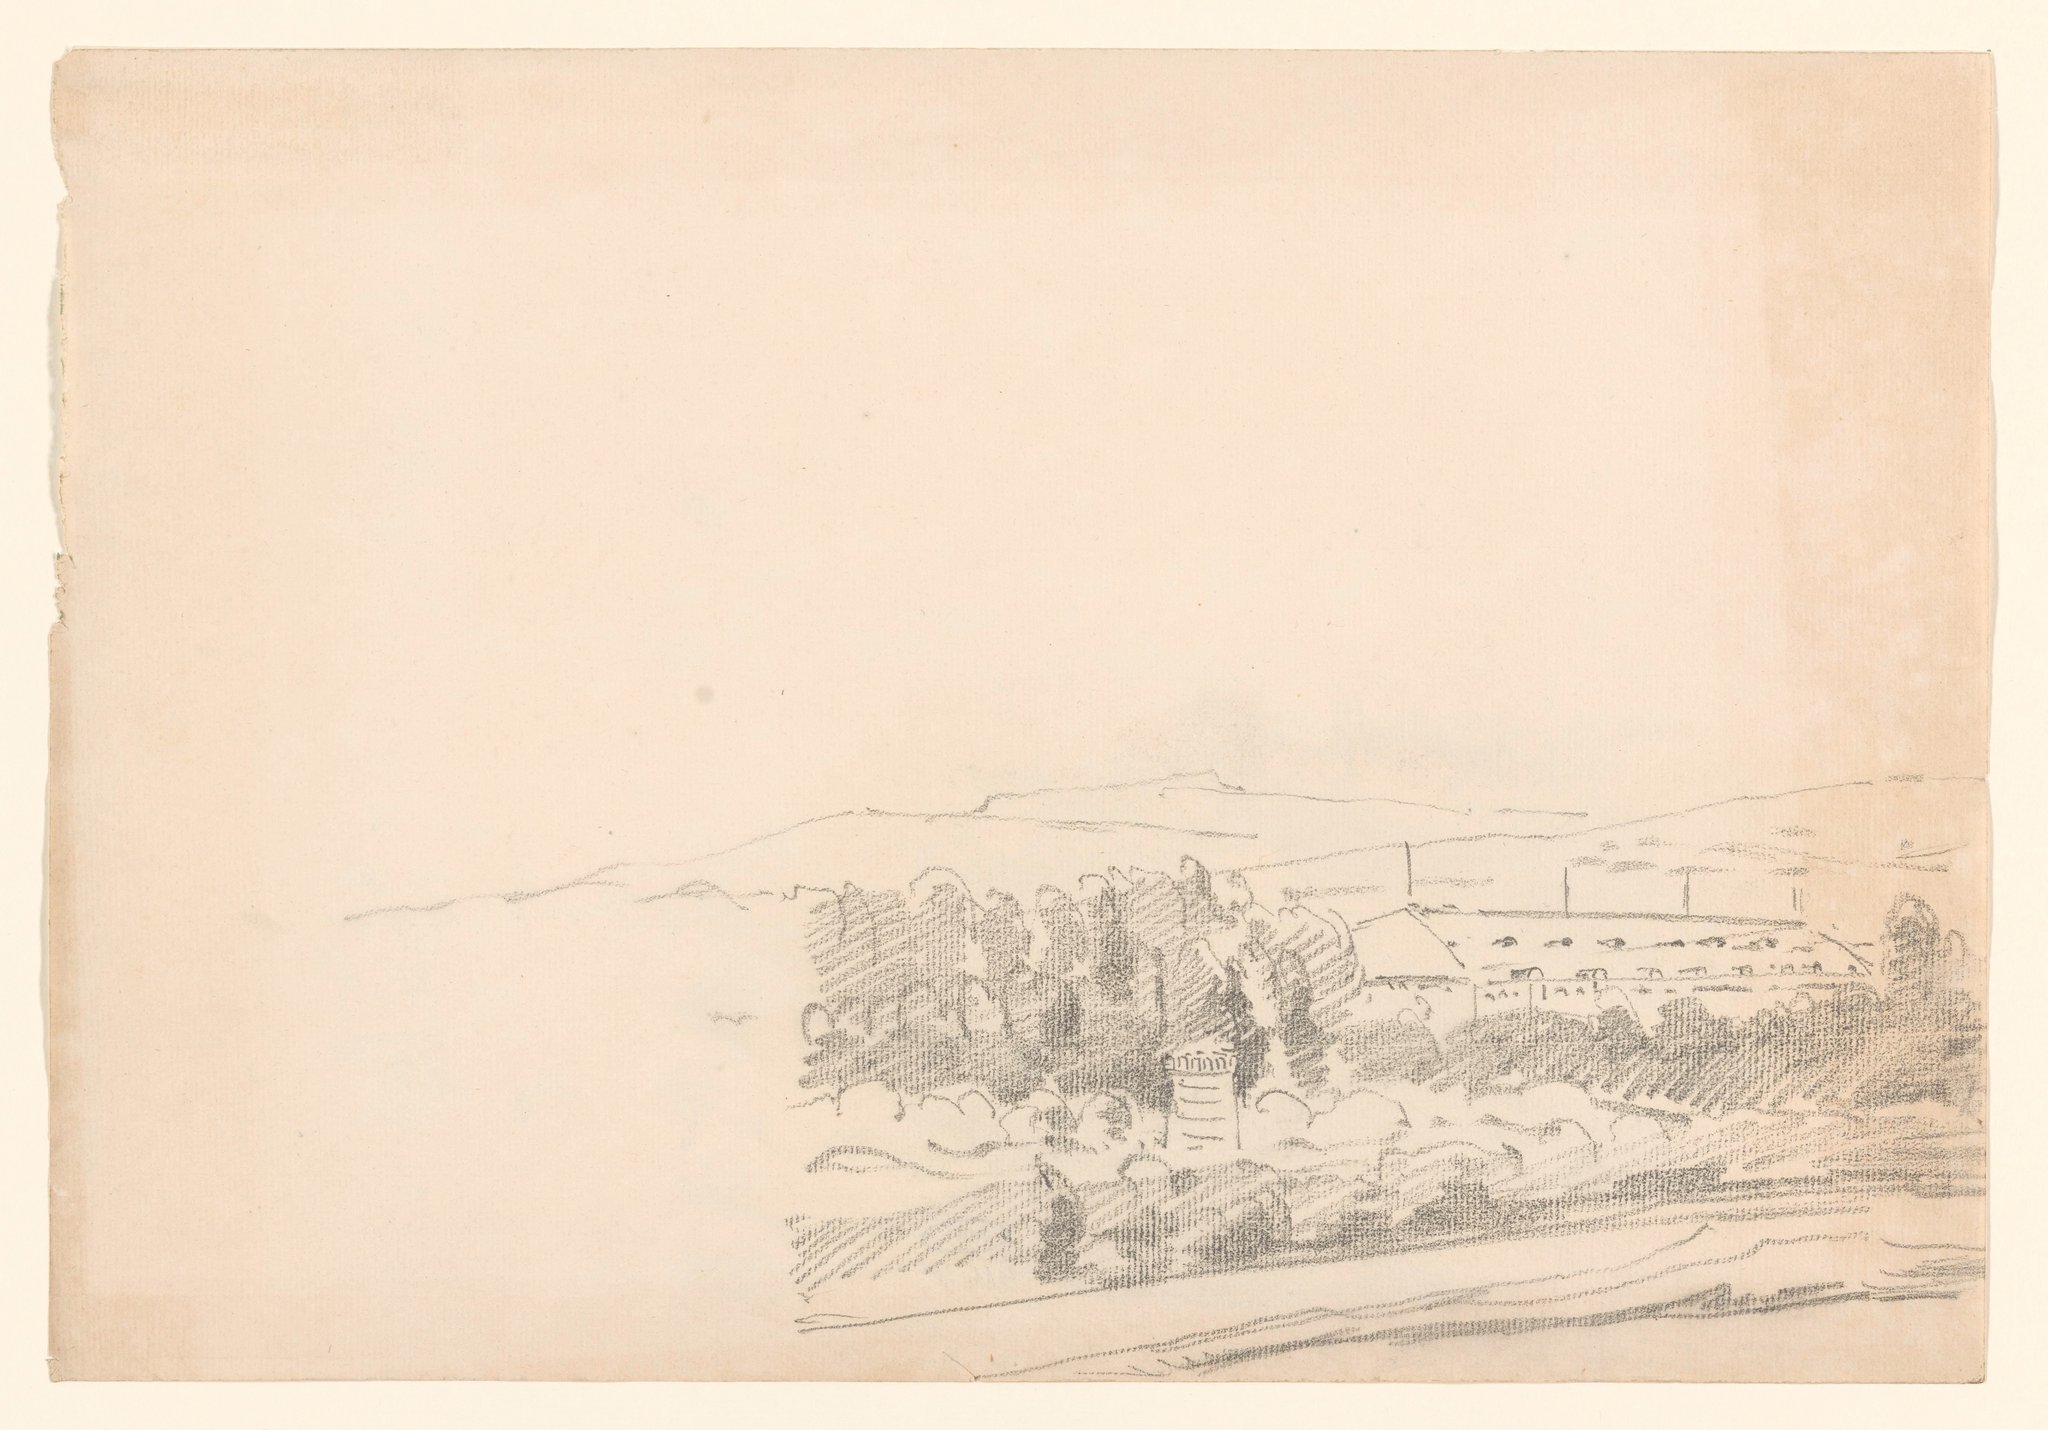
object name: drawing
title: Italiaans landschap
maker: carel vosmaer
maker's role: draughtsman, print maker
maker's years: 1826-1888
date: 1836-1888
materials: paper, pencil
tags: city-view, and landscape with man-made constructions, italy